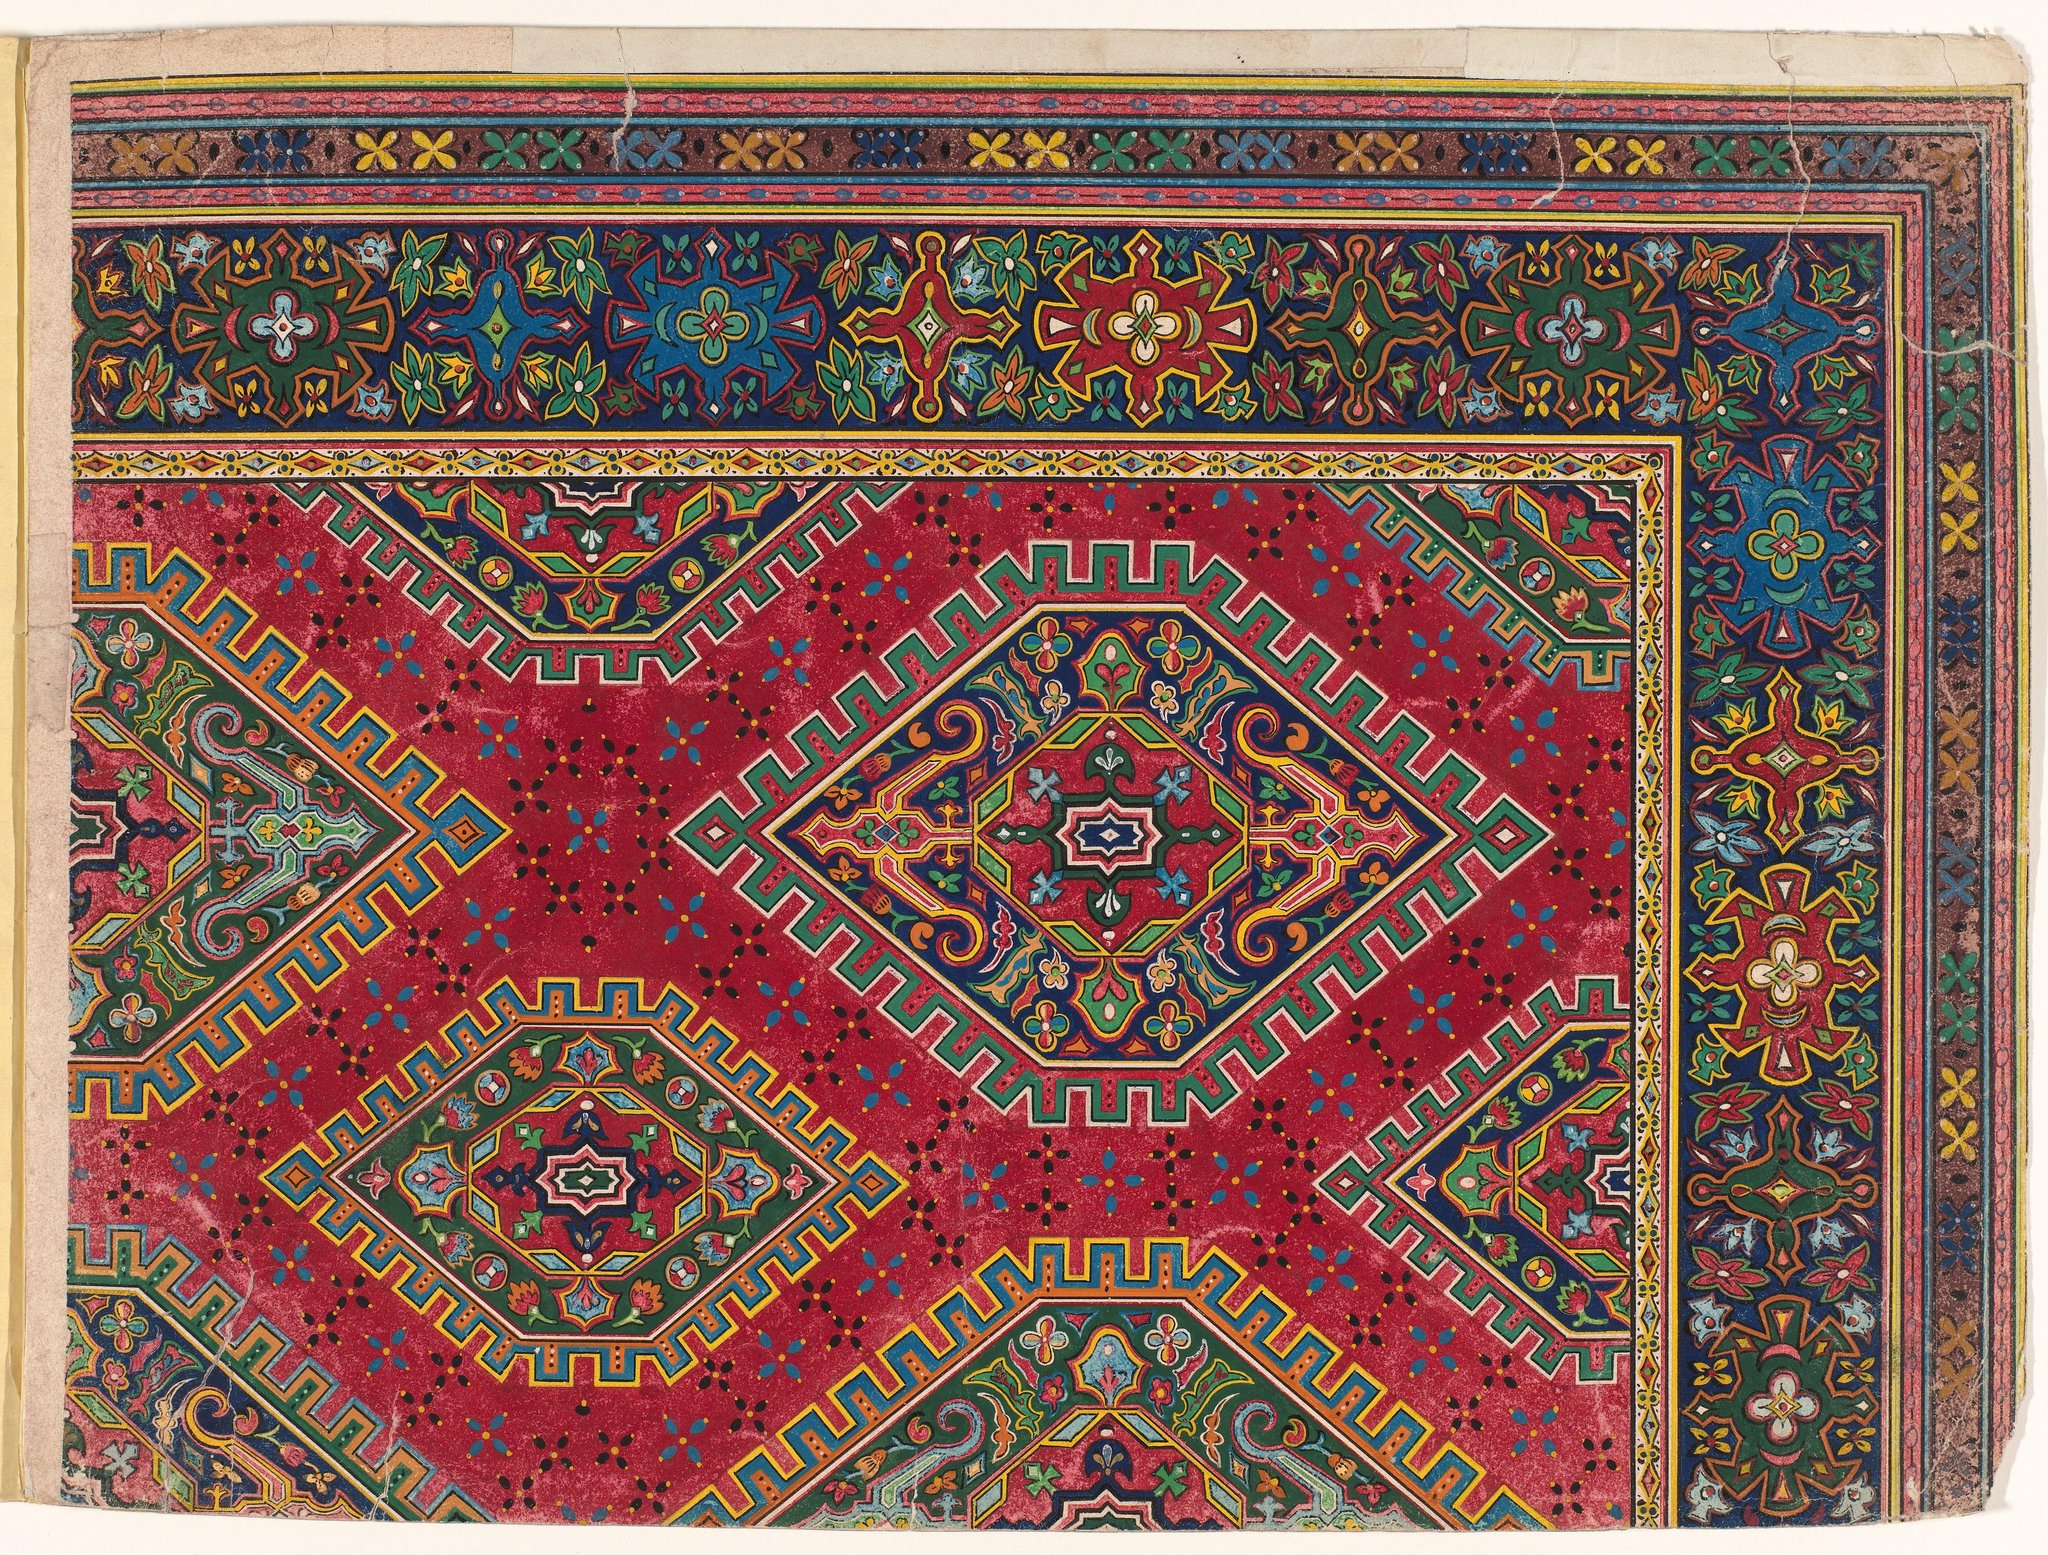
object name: drawing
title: Ontwerp voor een tapijt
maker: Anonymous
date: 1854-1864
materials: gouache, paper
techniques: brush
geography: amsterdam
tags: ornaments ~ art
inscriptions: number: ‘No 19.’, inscription: ‘E s.’, retailer's mark: ‘JHS.’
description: De presentatietekeningen BK-1971-77-1 t/m 86 zijn kopieën van de originele ontwerptekeningen. Ze werden gemaakt voor vertegenwoordigers van bijvoorbeeld magazijnen, die ze aan hun klanten konden tonen. De meeste tekeningen tonen een kwart van het dessin inclusief rand, middenpartij (de zogenaamde grond of fond) en centraal medaillon. Door het gebruik van spiegels kan de illusie van het gehele tapijt worden opgeroepen. Een deel van de tekeningen heeft een alfabetische opeenvolgende letter als kenmerk, de andere groep een cijfer.Waarschijnlijk is de reeks dessins met een letter eerder samengesteld dan de genummerde tekeningen.